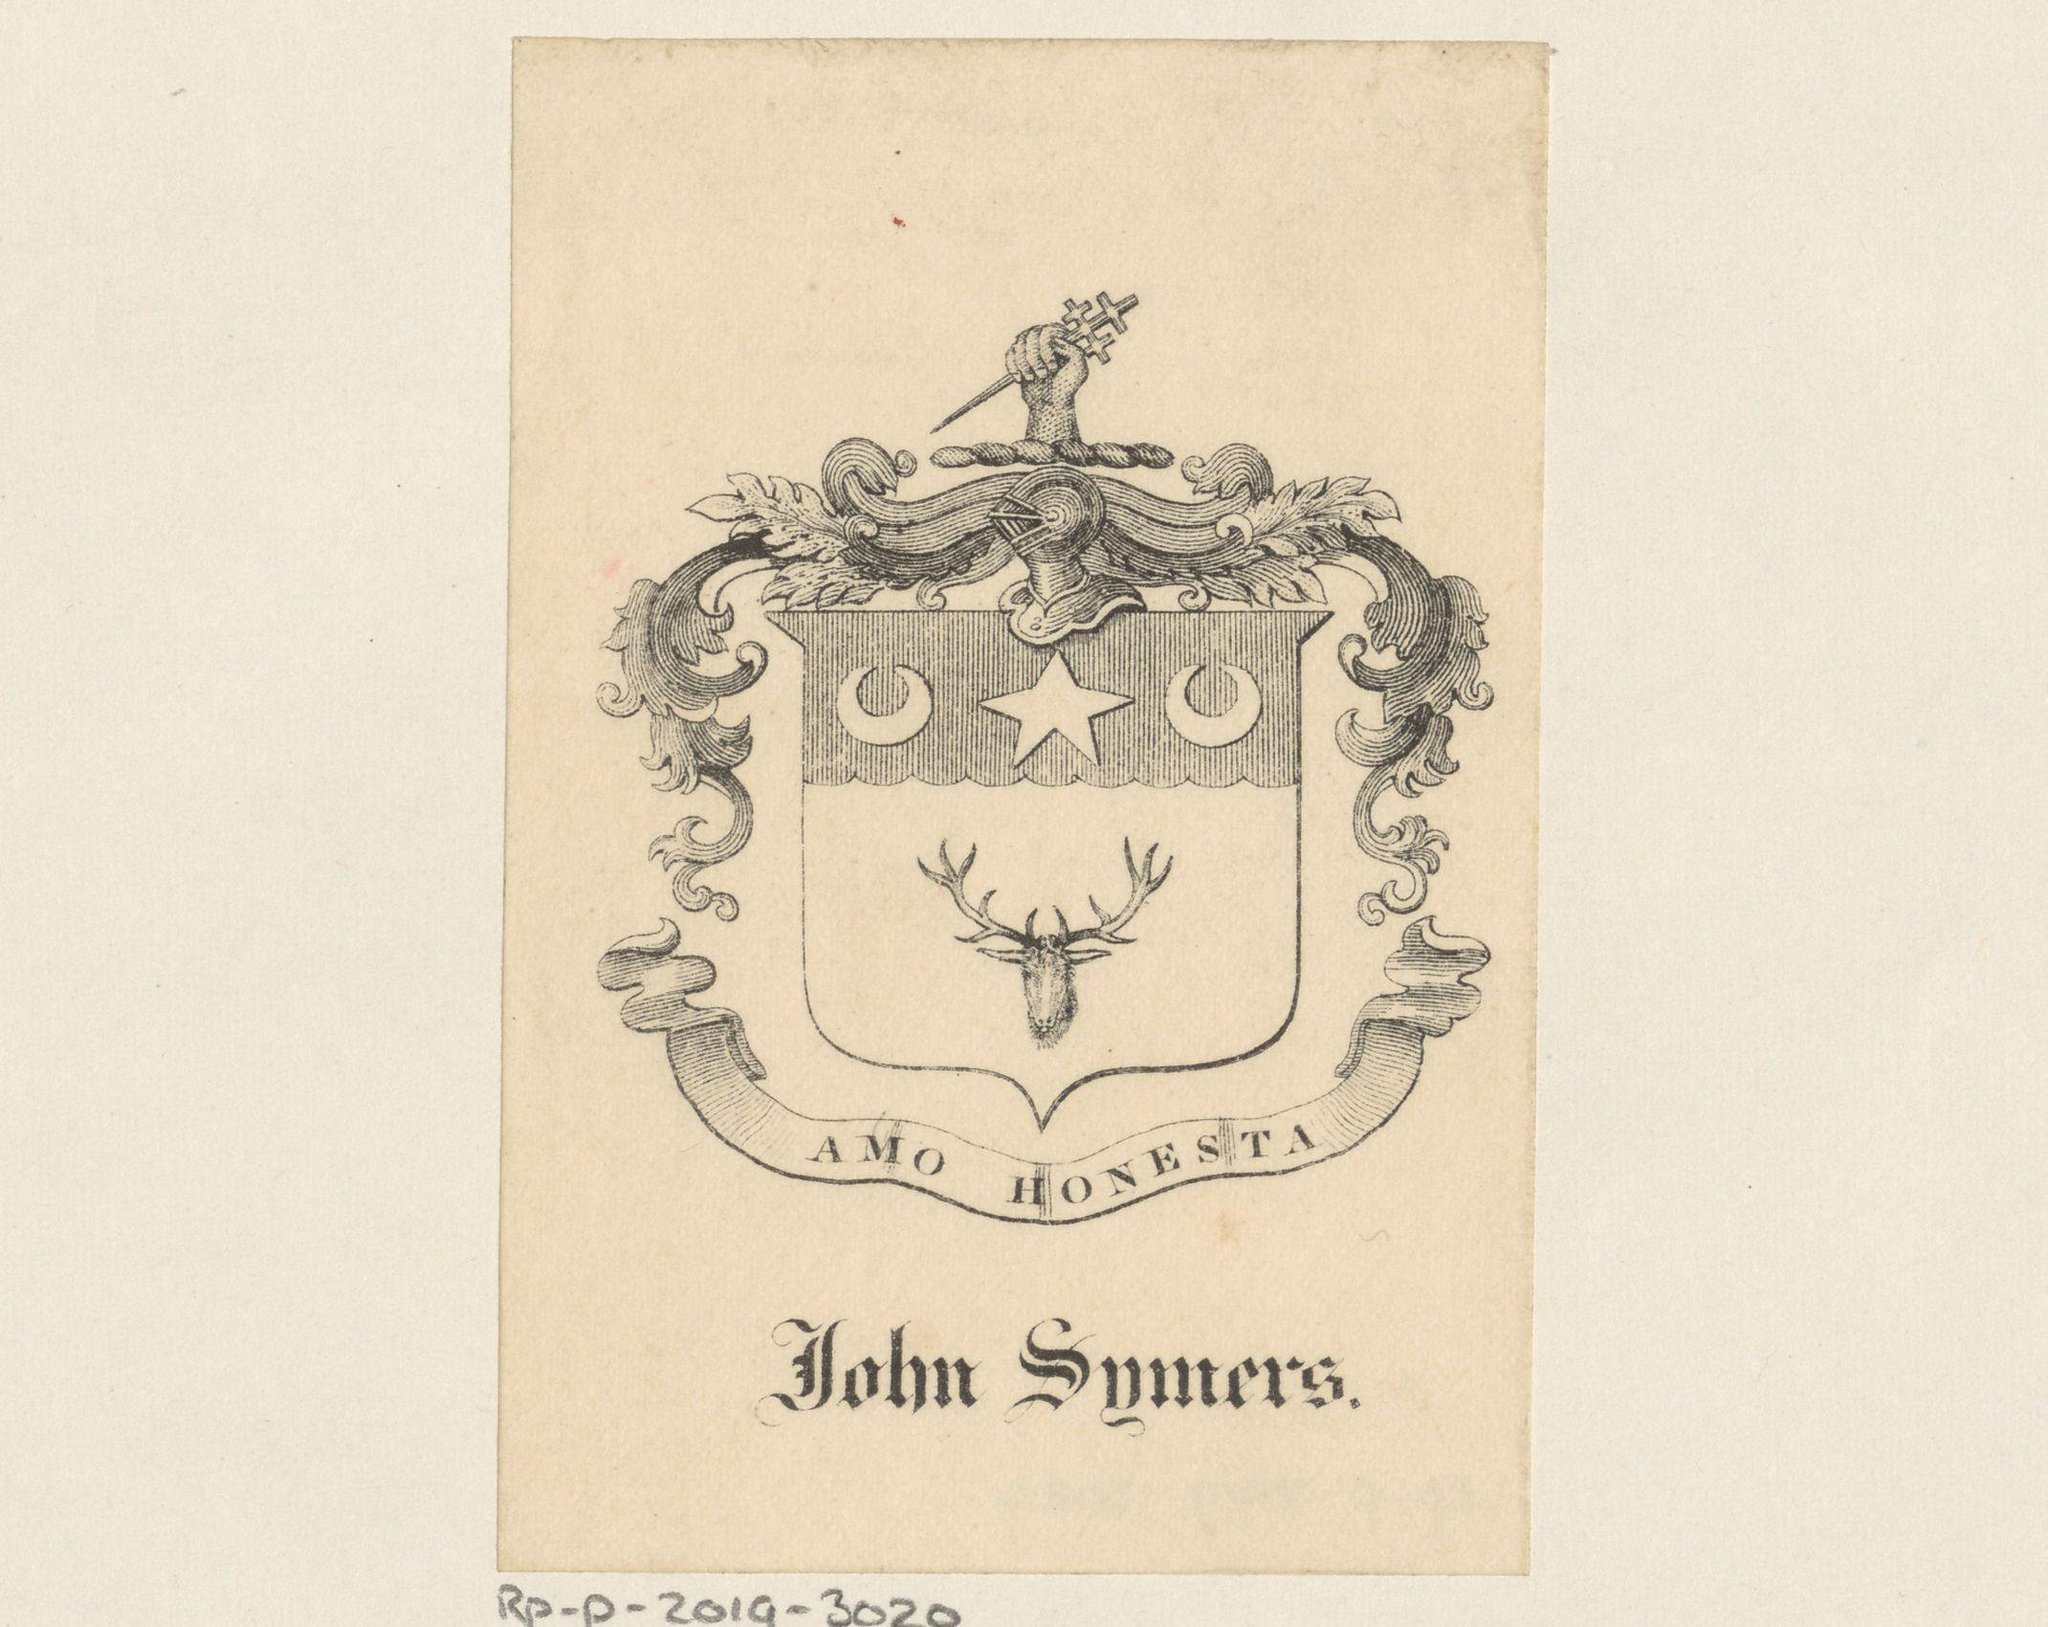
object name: bookplate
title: Ex libris van John Symers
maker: Anonymous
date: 1800-1899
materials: paper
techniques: etching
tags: armorial bearing, heraldry